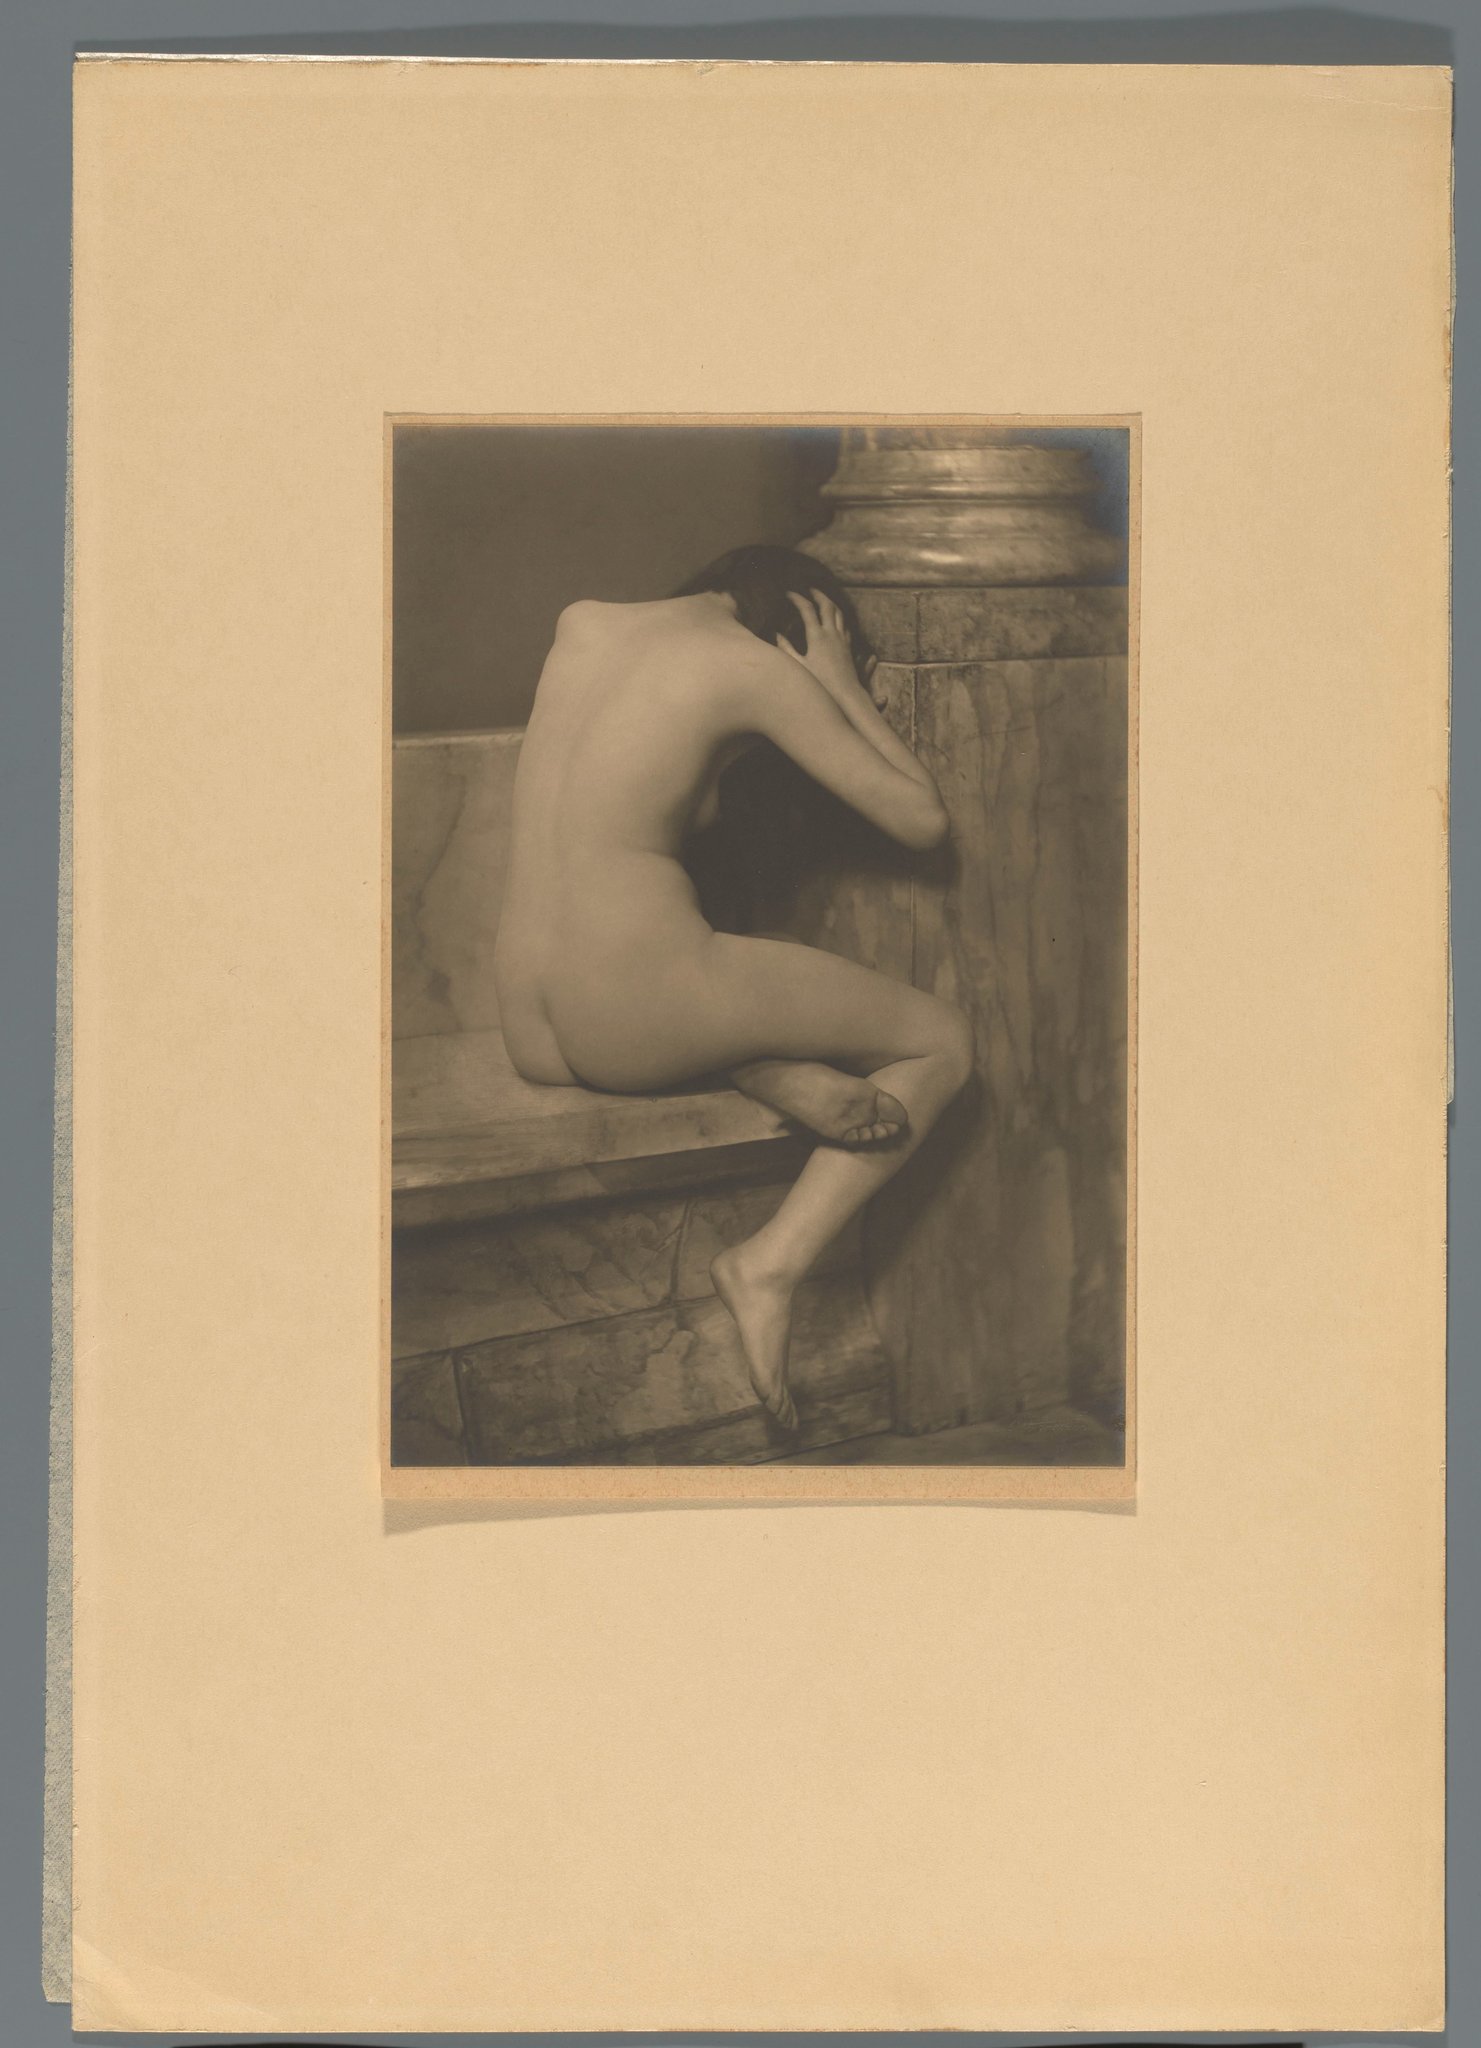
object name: photograph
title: Portret van Mies Rosenboom-Merkelbach als zittend naakt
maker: jacob merkelbach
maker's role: fotograaf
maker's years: 1877-1942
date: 1925-1940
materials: cardboard, paper, photographic support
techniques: gelatin silver print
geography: amsterdam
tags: historical persons (portraits and scenes from the life) - bb - woman, the (nude) human figure; 'corpo humano' (ripa) - aa - female human figure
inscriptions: annotation: ‘Foto Merkelbach Mies Roosenboom Merkelbach ... gaslichtpapier’